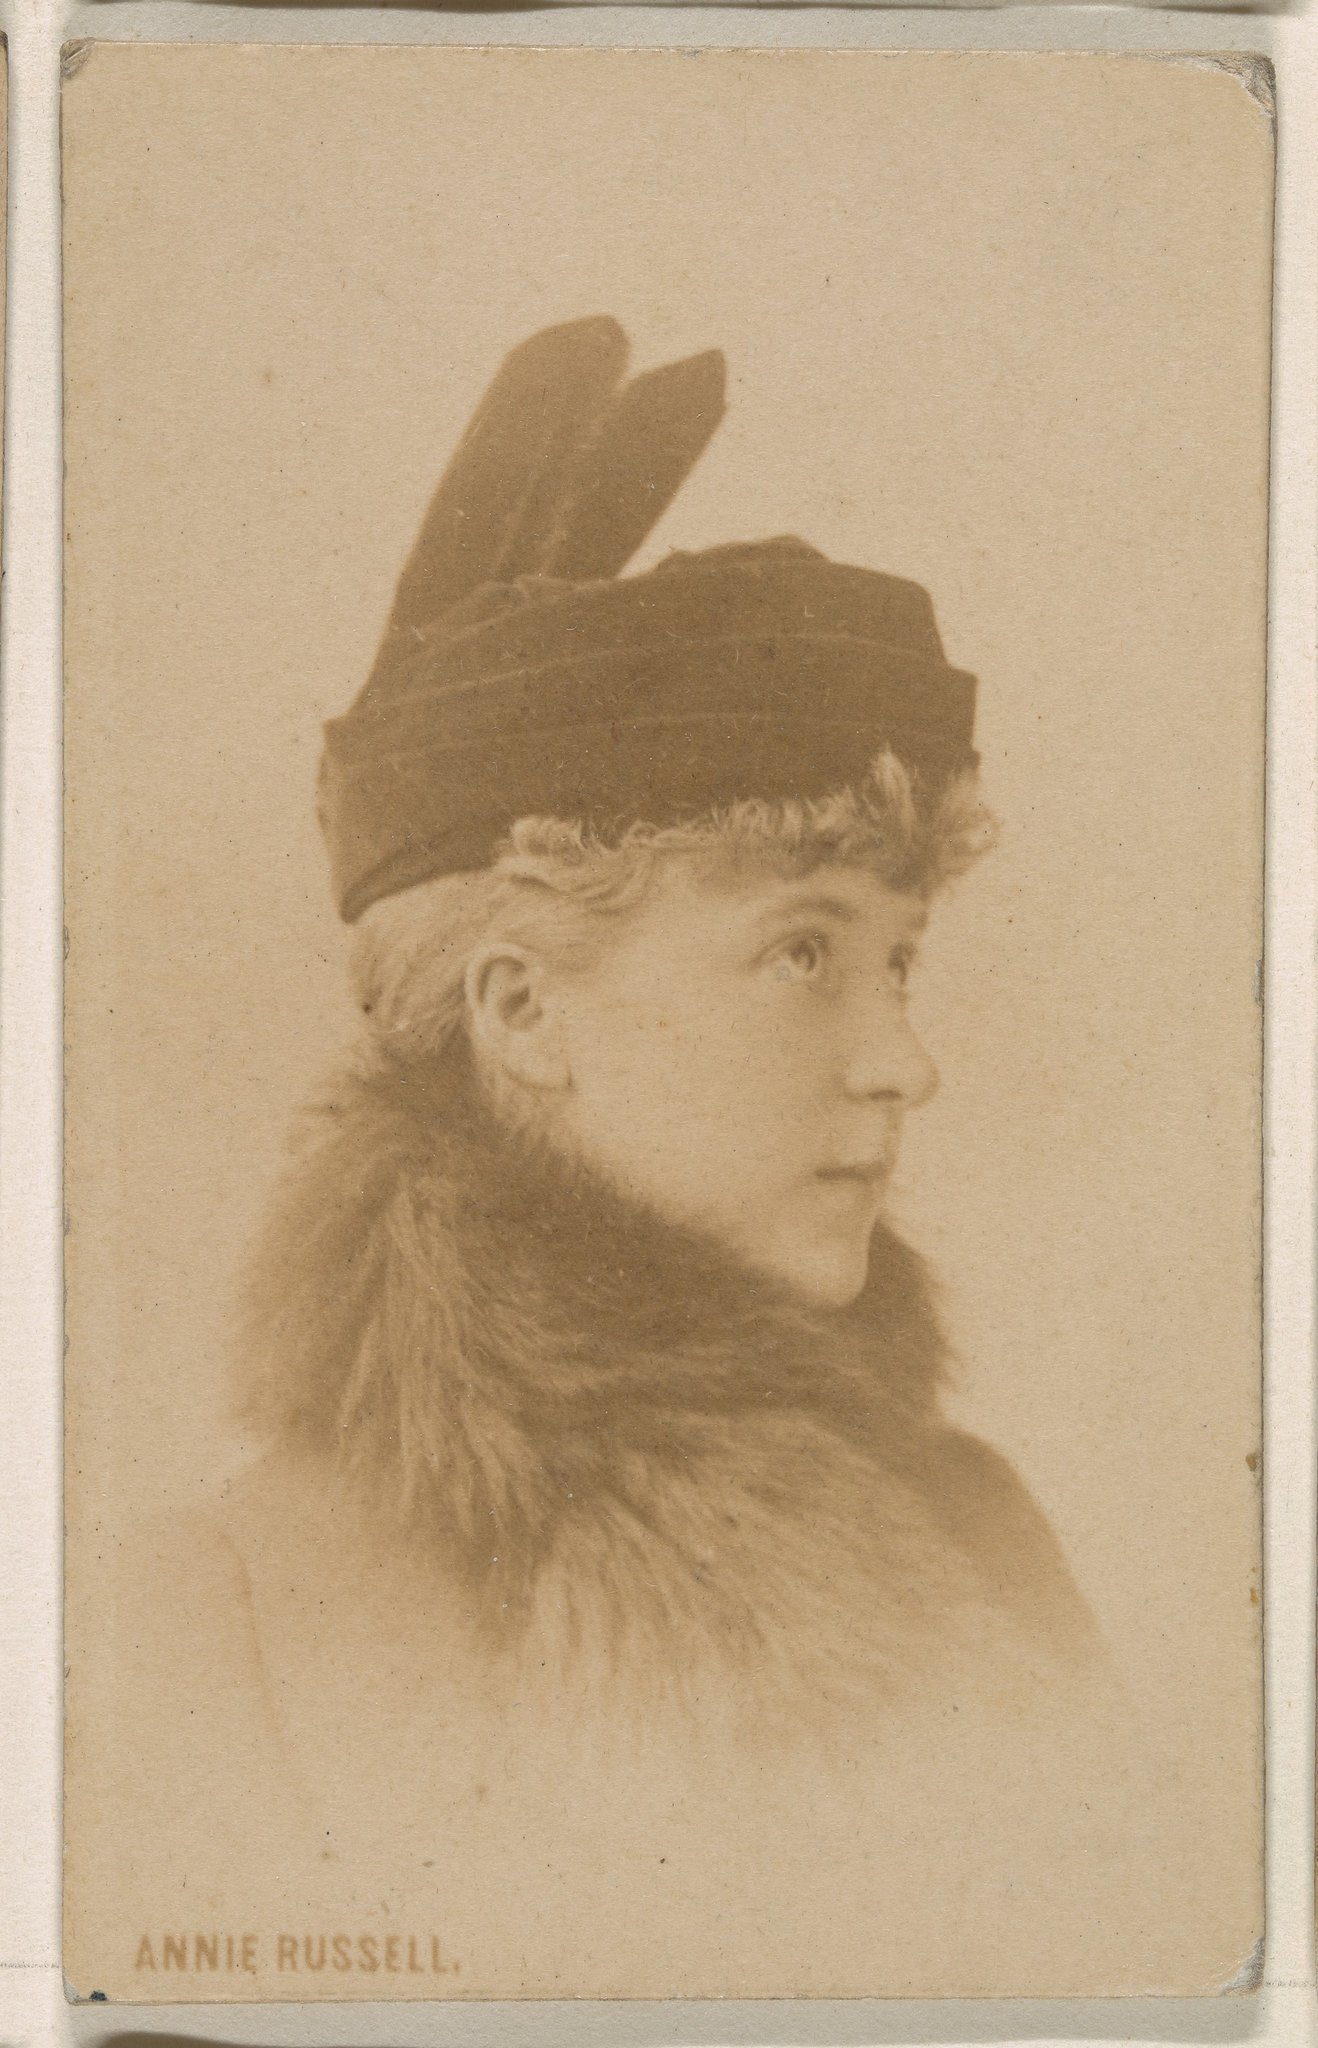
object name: photograph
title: Annie Russell, from the Actresses series (N246), Type 1, issued by Kinney Brothers to promote Sporting Extra Cigarettes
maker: kinney brothers tobacco company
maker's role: publisher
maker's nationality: american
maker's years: 1869-2011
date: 1890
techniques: albumen silver print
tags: portraits,women,actresses